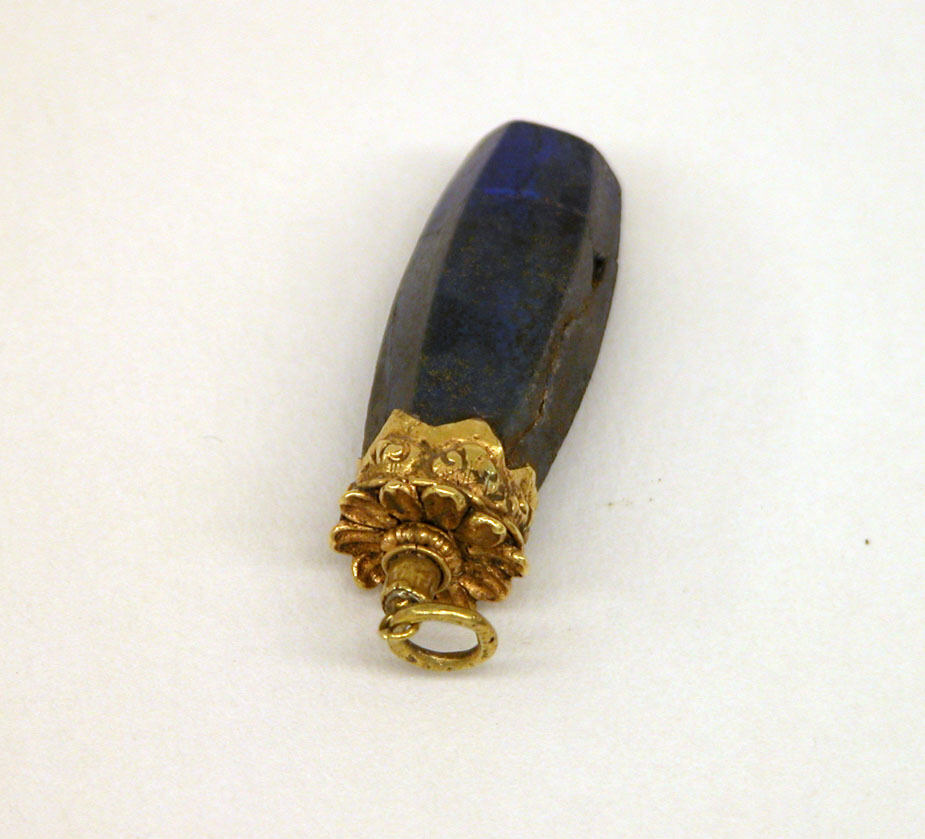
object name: pendant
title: Lapis Pendant with Gold Mount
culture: indonesian, javanese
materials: gold